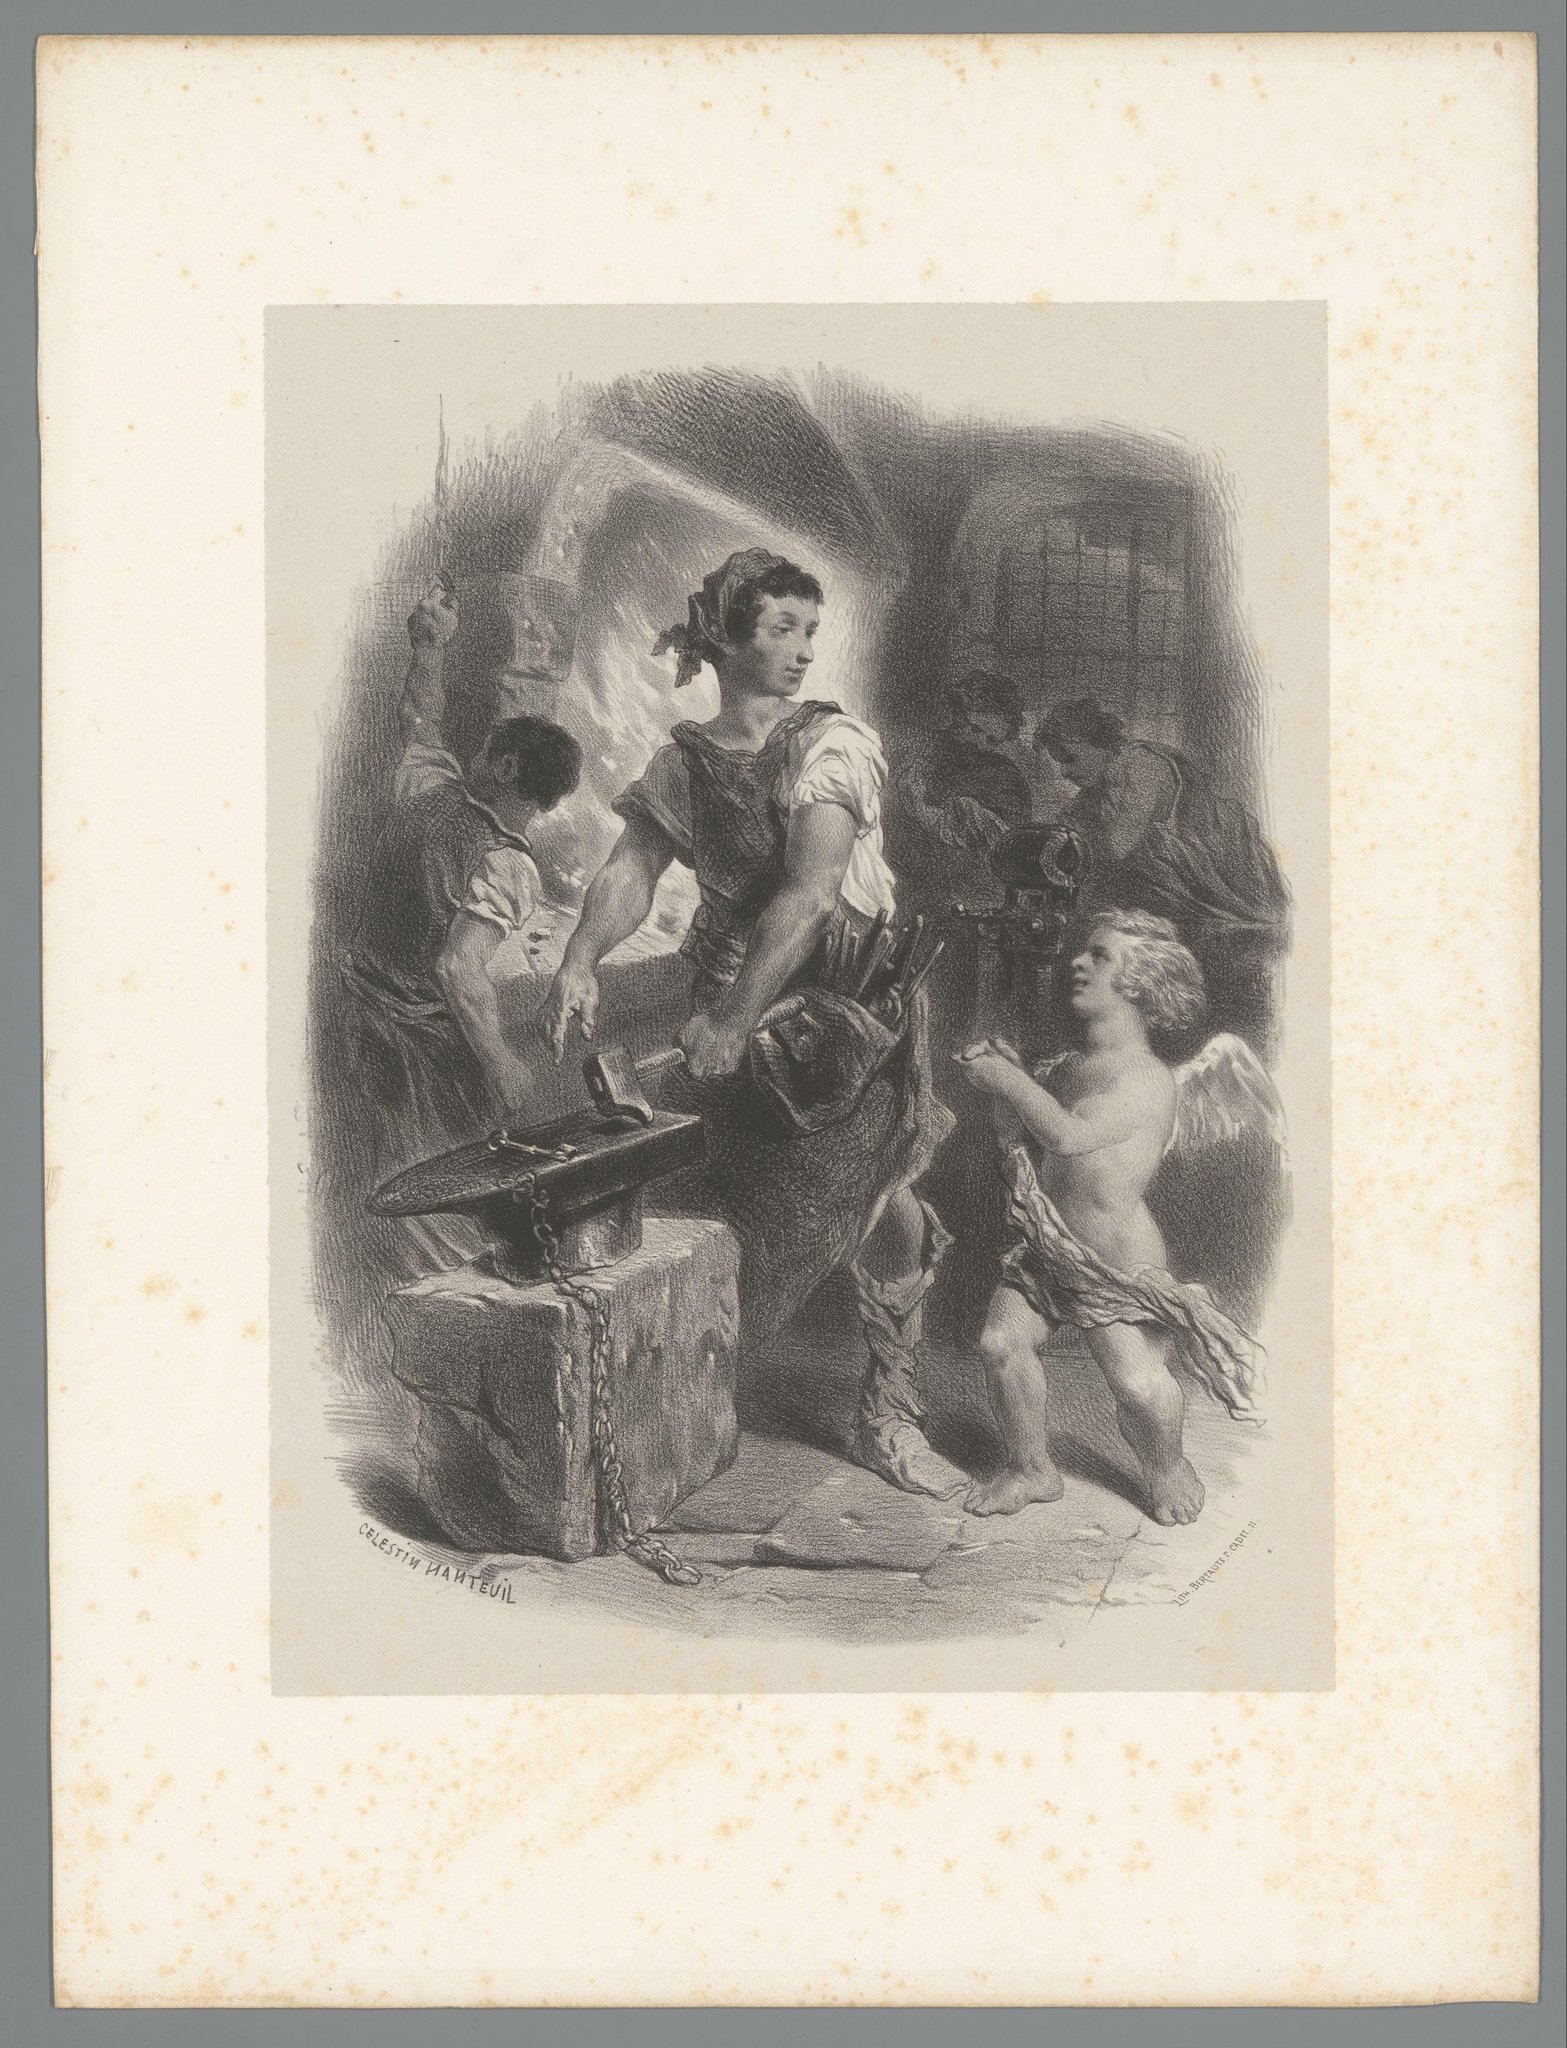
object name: print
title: Sleutelmaker aan het werk vergezeld door Amor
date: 1851-1865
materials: paper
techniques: lithograph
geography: paris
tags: lock-smith, tools, aids, implements ~ crafts and industries: hammer, fire, oven, furnace ~ interior of industrial structure, (story of) cupid, amor (eros), tools, aids, implements ~ crafts and industries: anvil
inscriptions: collector's mark: Lugt 964